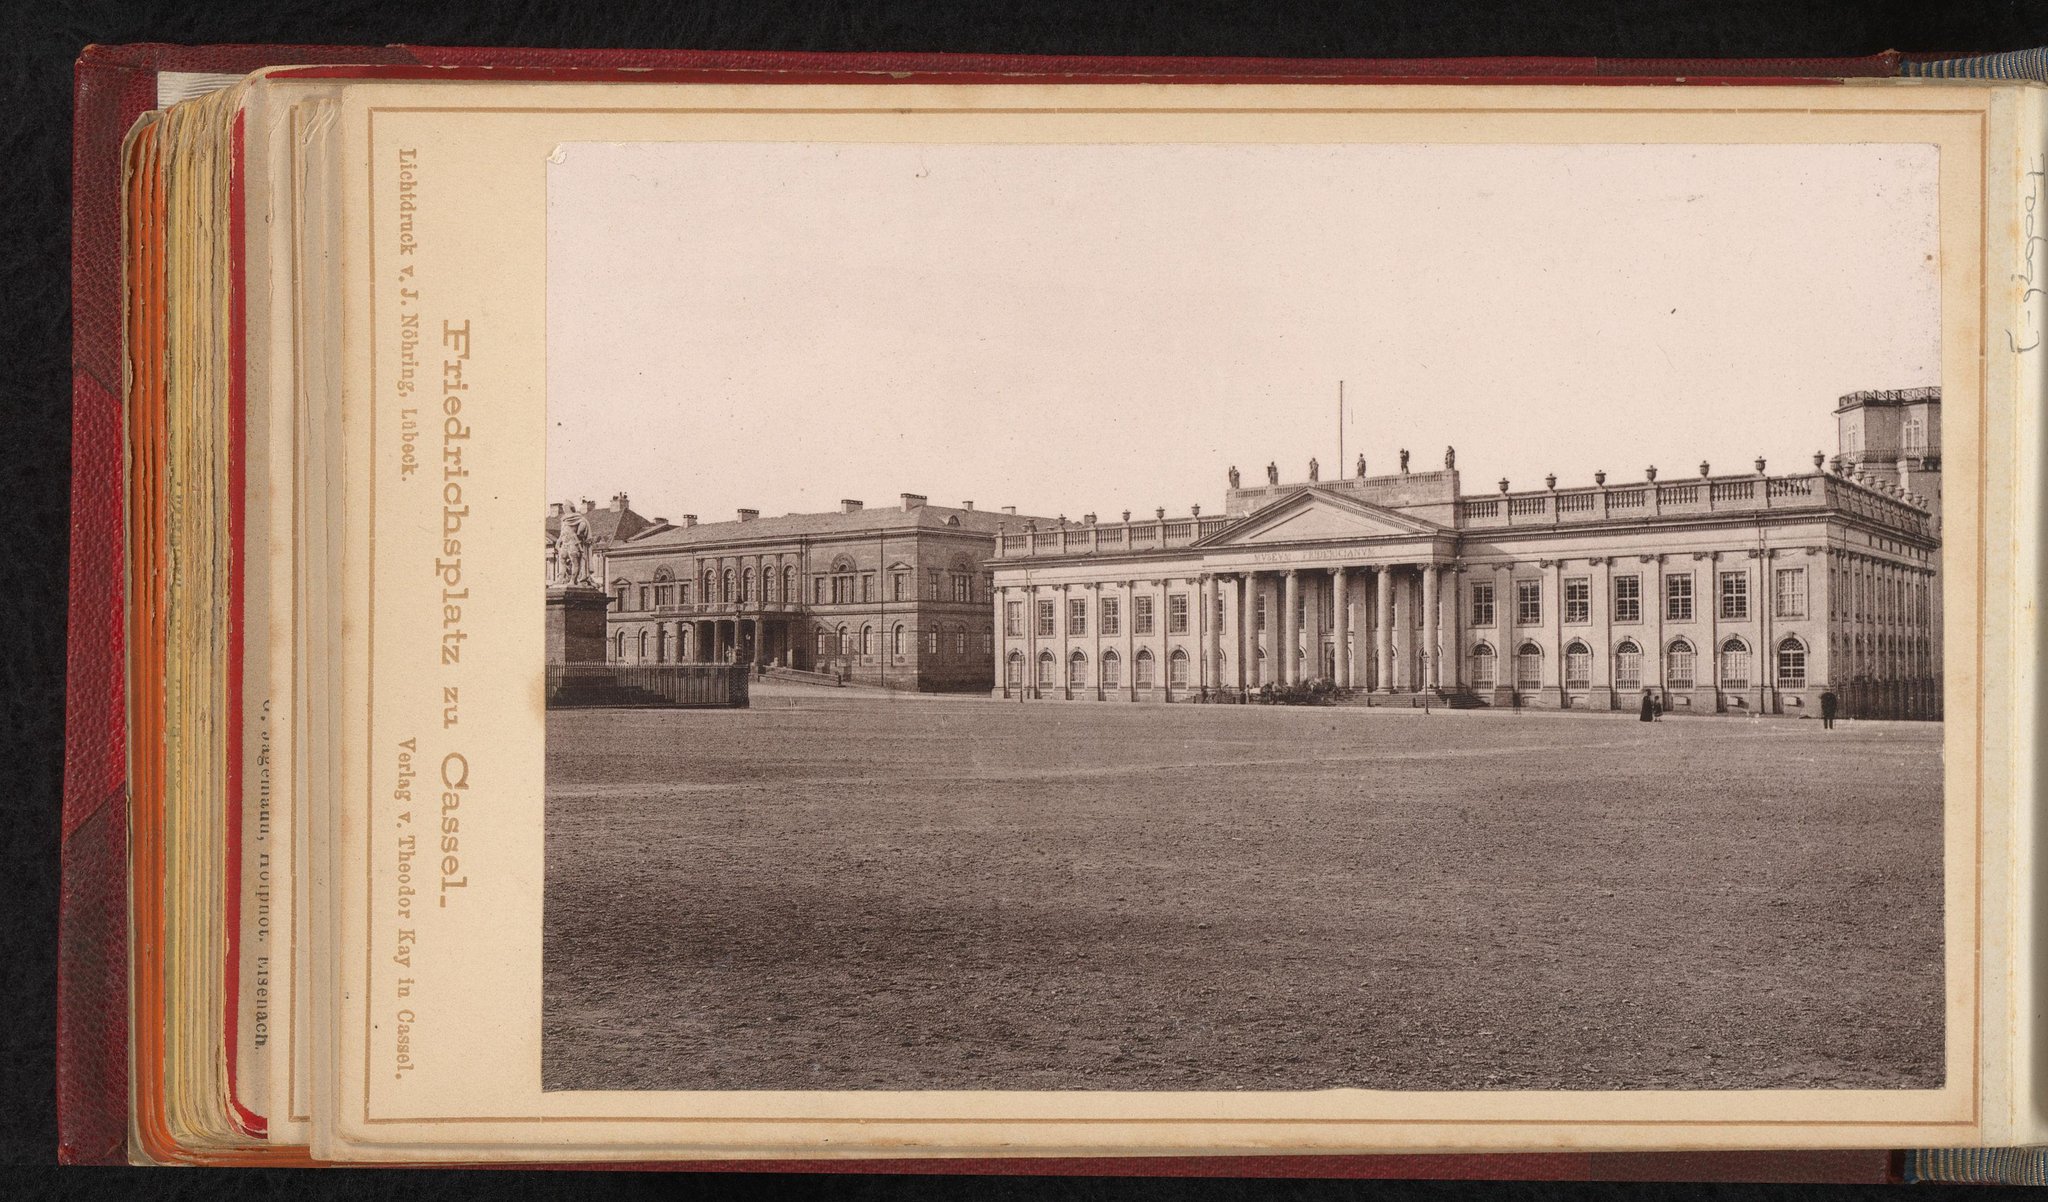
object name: cabinet photograph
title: Gezicht op het Fridericianum aan de Friedrichsplatz in Kassel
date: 1870-1890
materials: cardboard, paper, photographic support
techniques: photograph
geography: kassel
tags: travelling; tourism, permanent exhibition, museum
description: Onderdeel van Album met 38 foto's van een reis door de Harz.